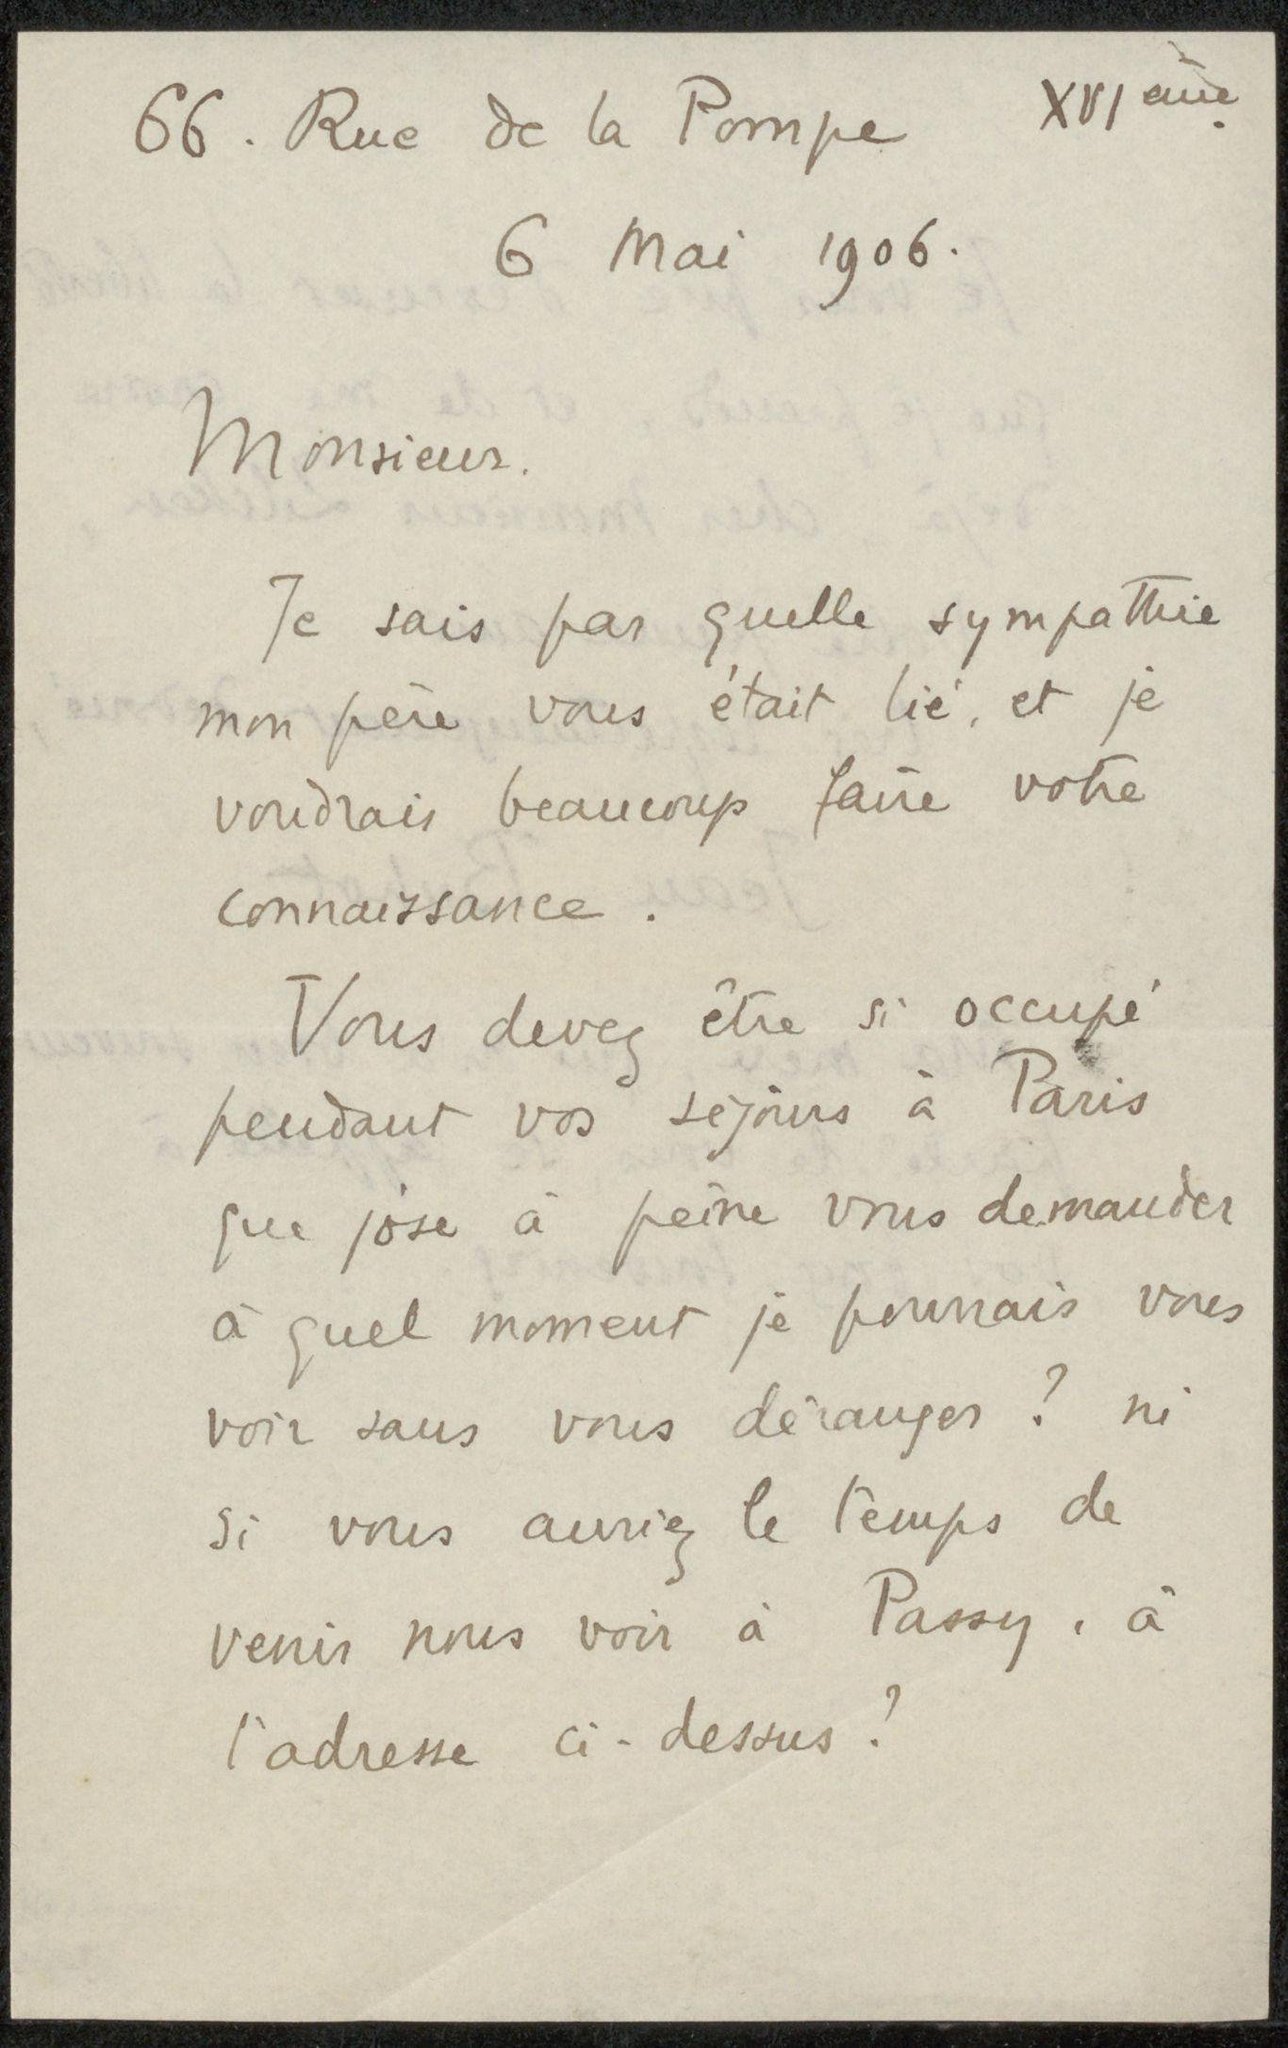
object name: letter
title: Brief aan Philip Zilcken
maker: jean buhot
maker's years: 1885-1952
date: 1906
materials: ink, paper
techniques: pen, writing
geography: paris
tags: the hague, painter, draughtsman, philip zilcken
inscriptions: collector's mark: ‘RPK’